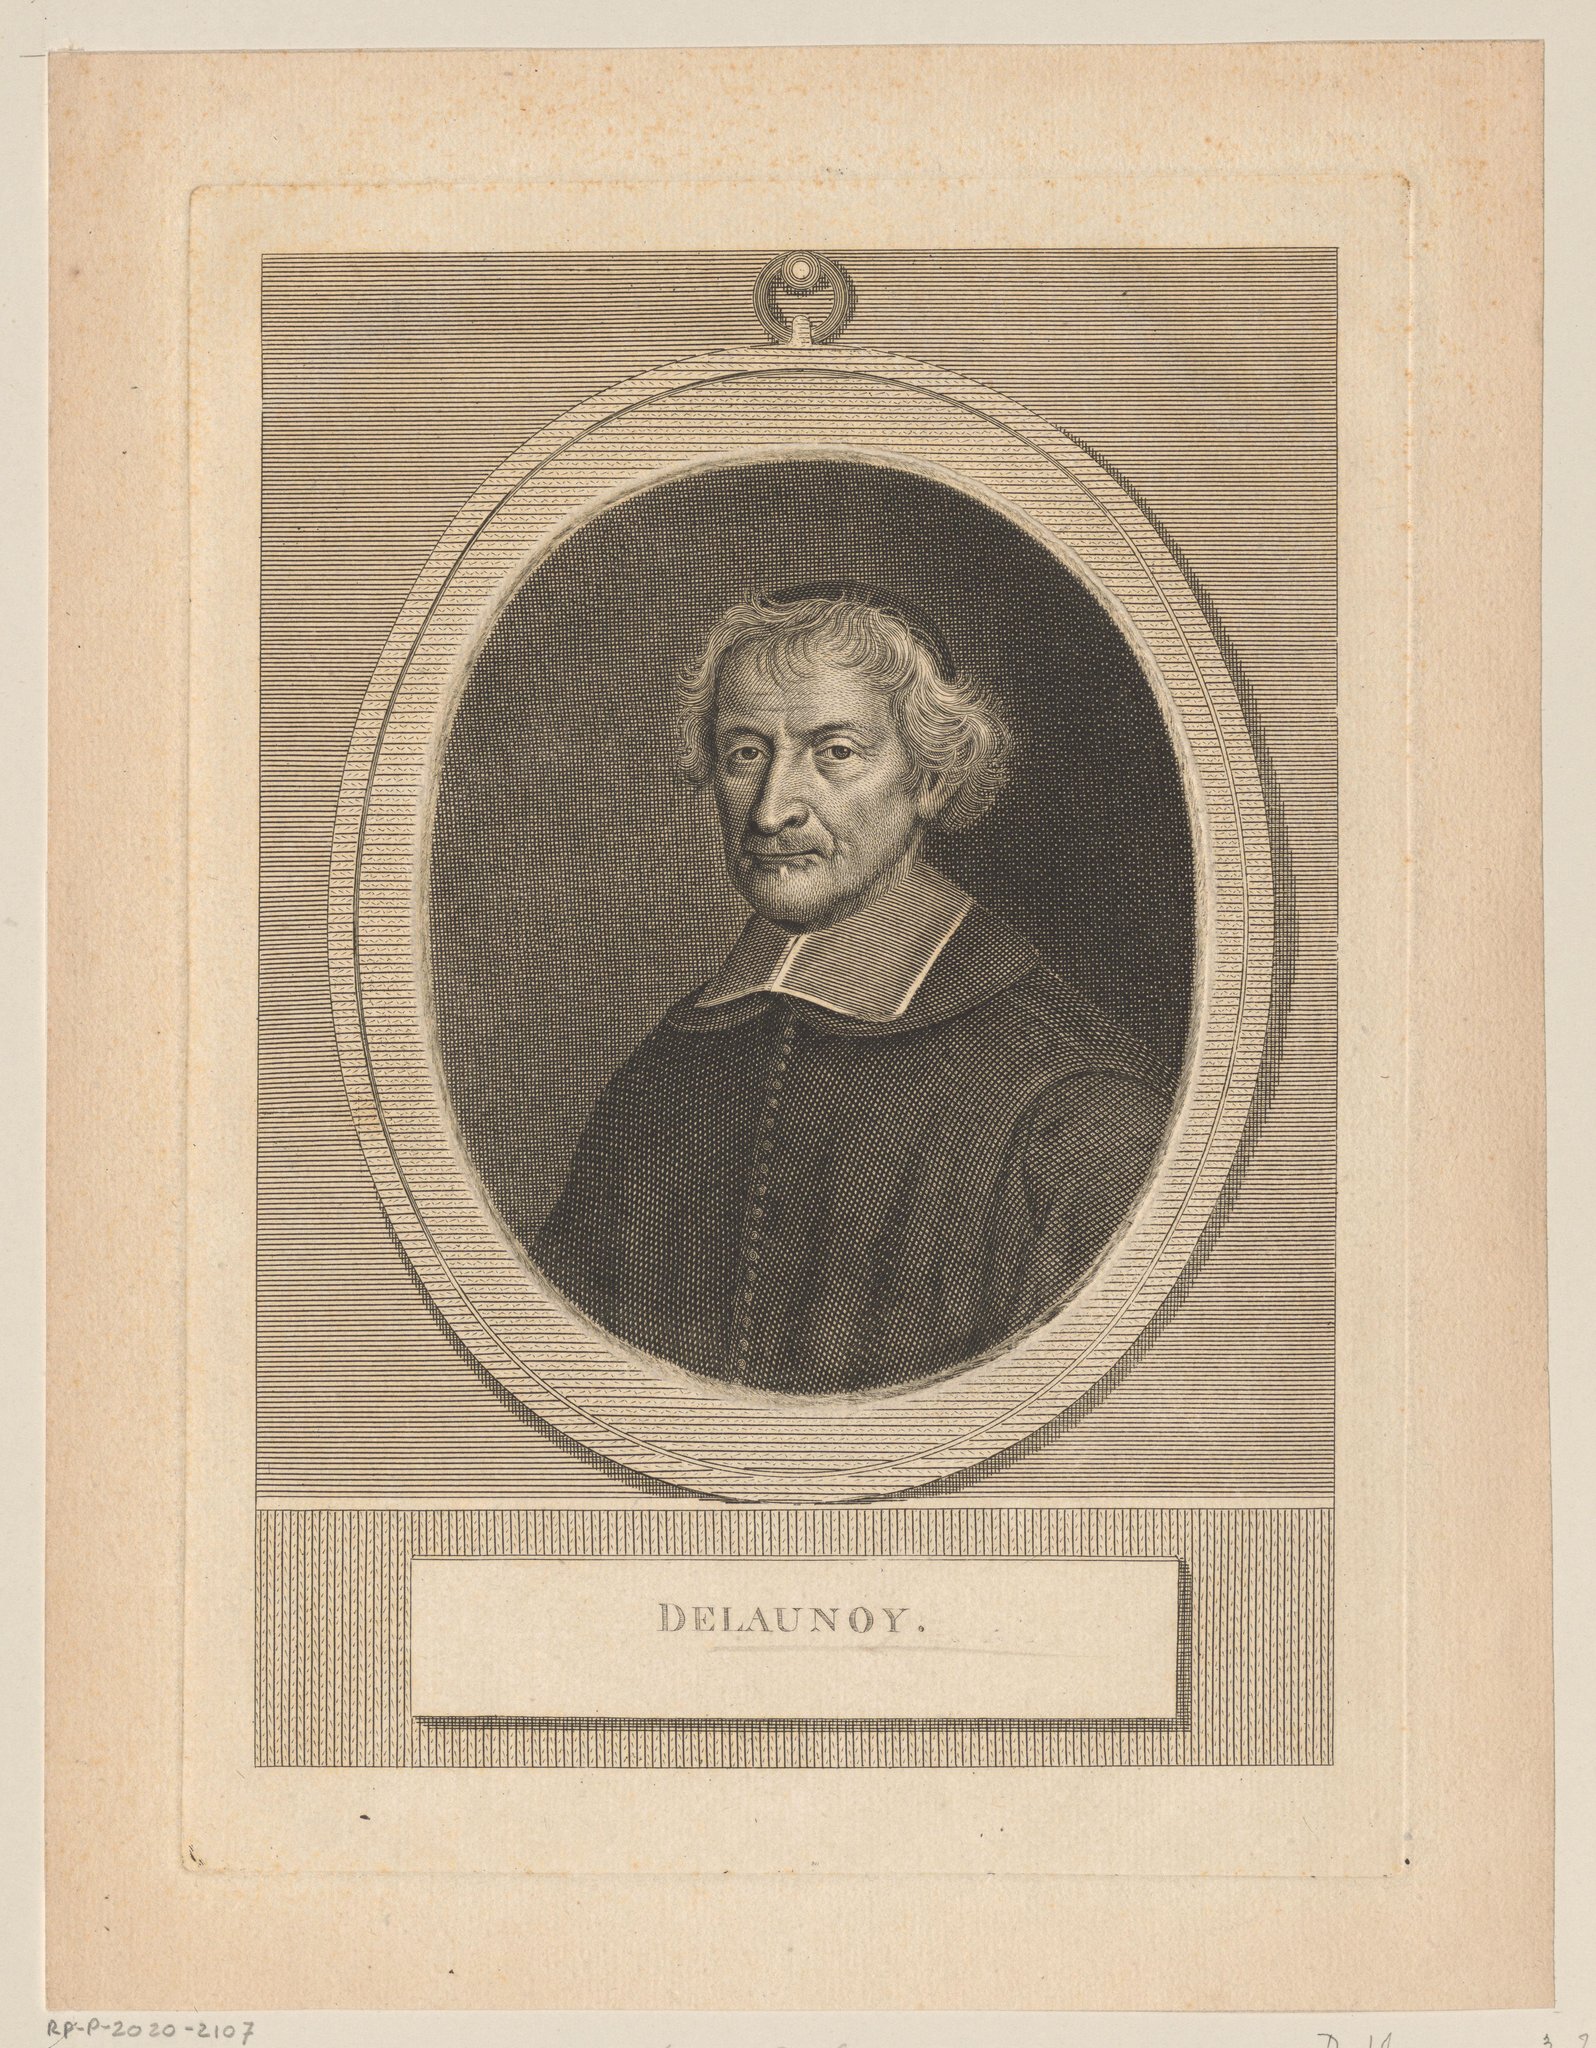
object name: print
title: Portret van Jean de Launoy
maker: Anonymous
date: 1650-1749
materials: paper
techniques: engraving, etching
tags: paris, priest, theologian, historical persons